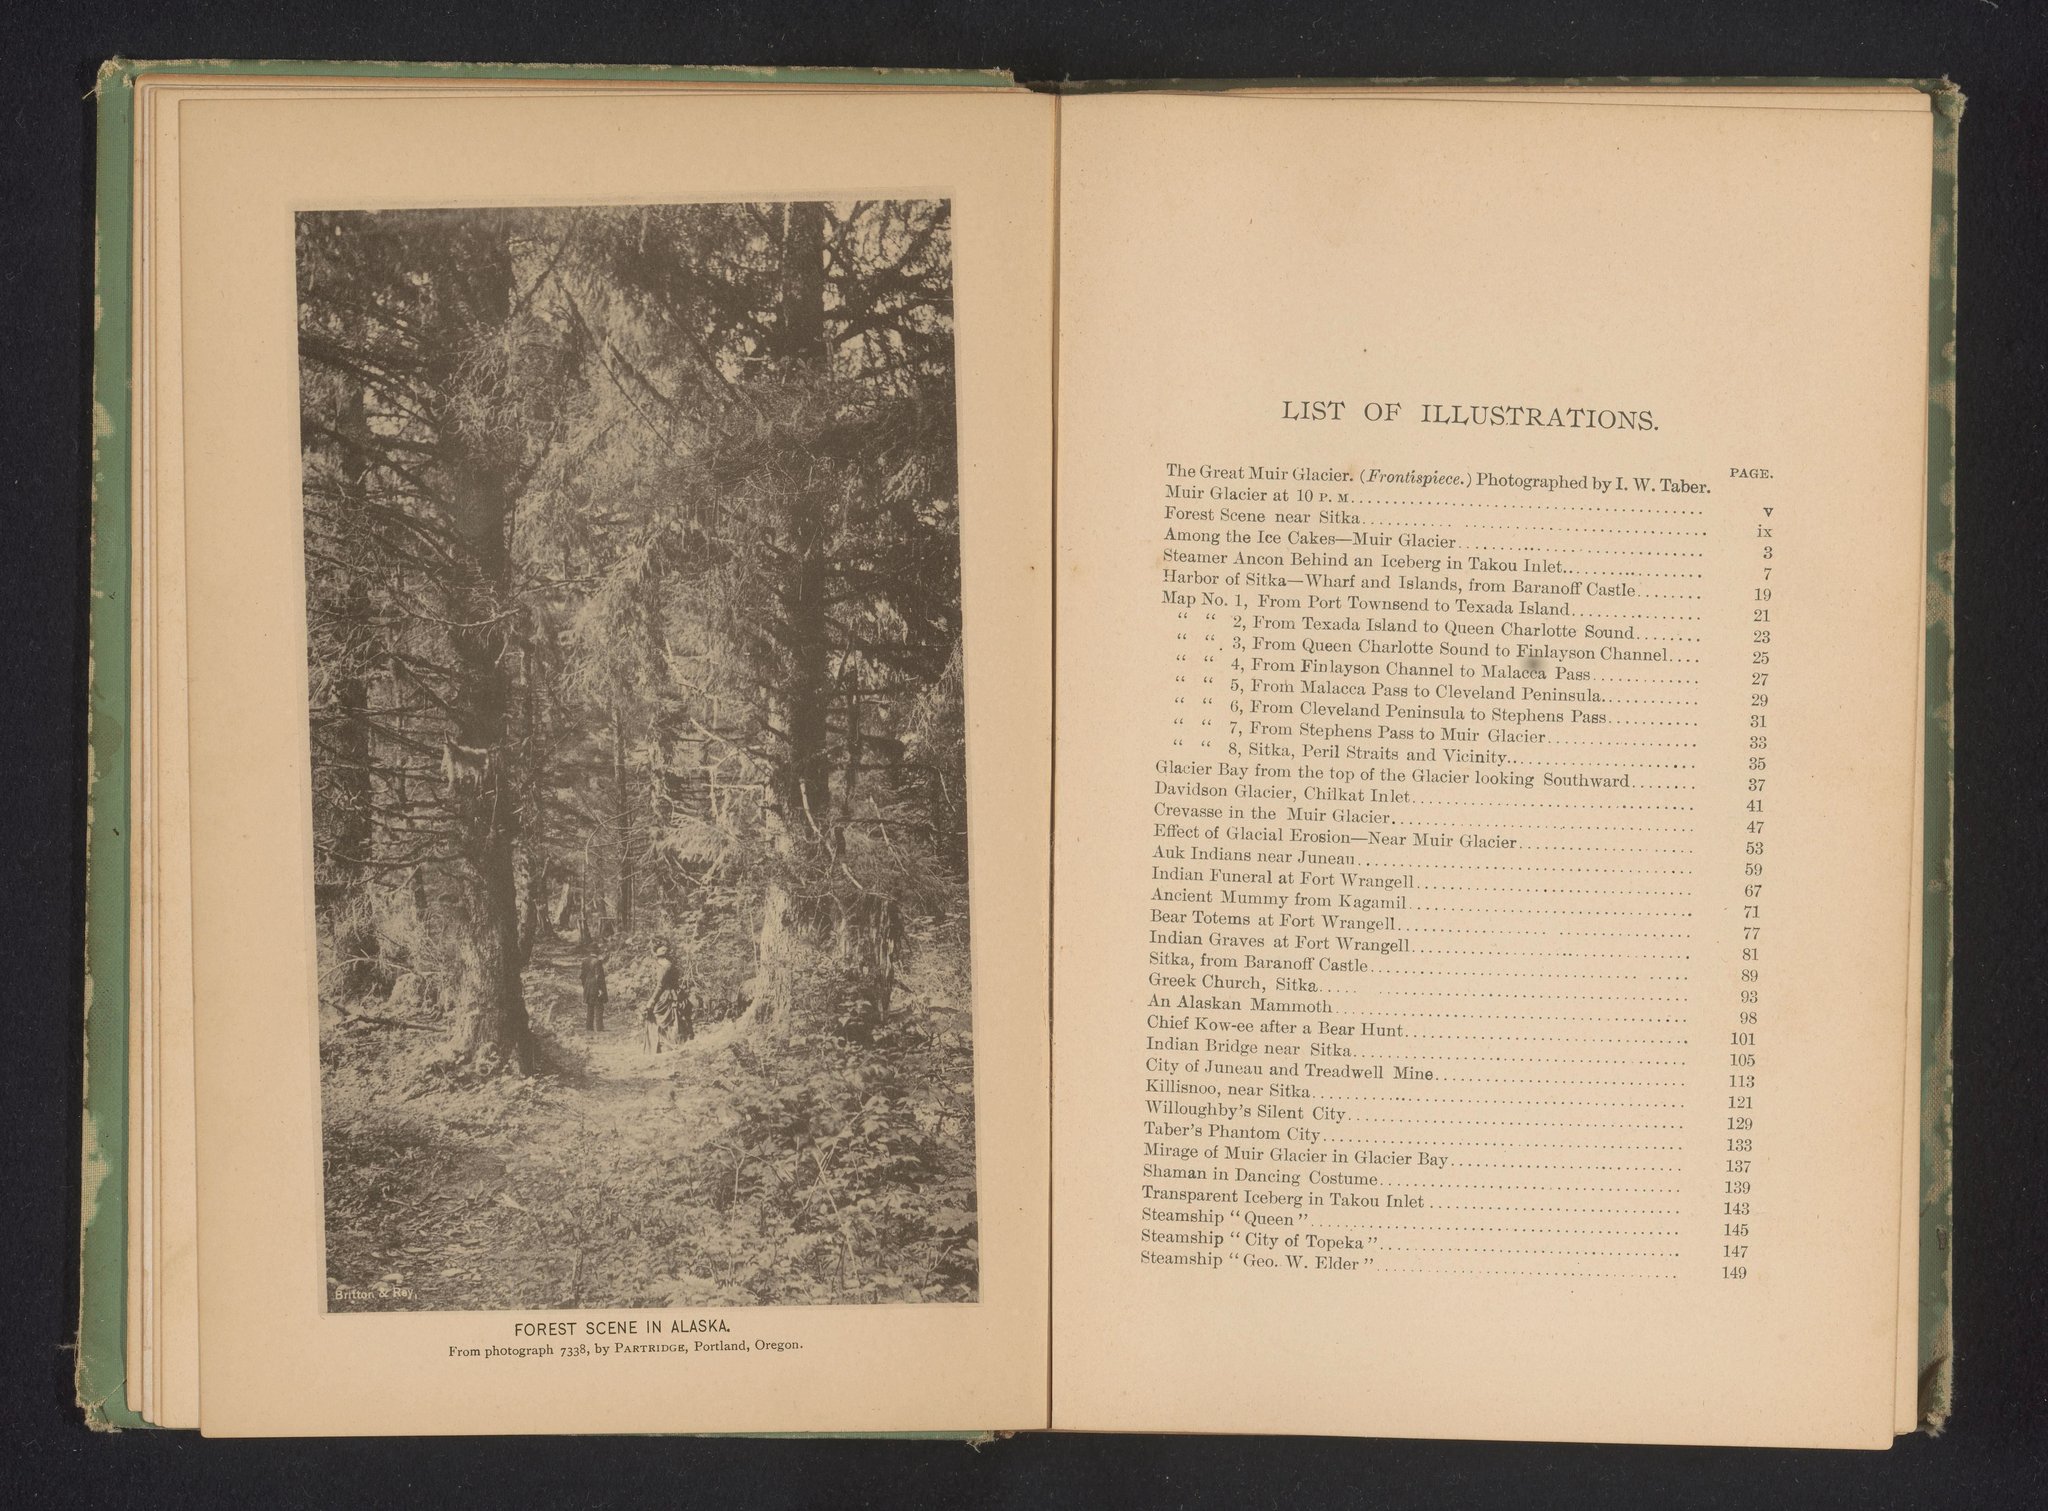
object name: page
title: Forest scene in Alaska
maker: william henry partridge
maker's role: fotograaf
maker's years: 1858-1939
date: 1885-1890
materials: paper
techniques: photograph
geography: sitka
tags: historical persons, forest, wood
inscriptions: inscription: ‘From photograph 7338, by Partridge, Portland Oregon’